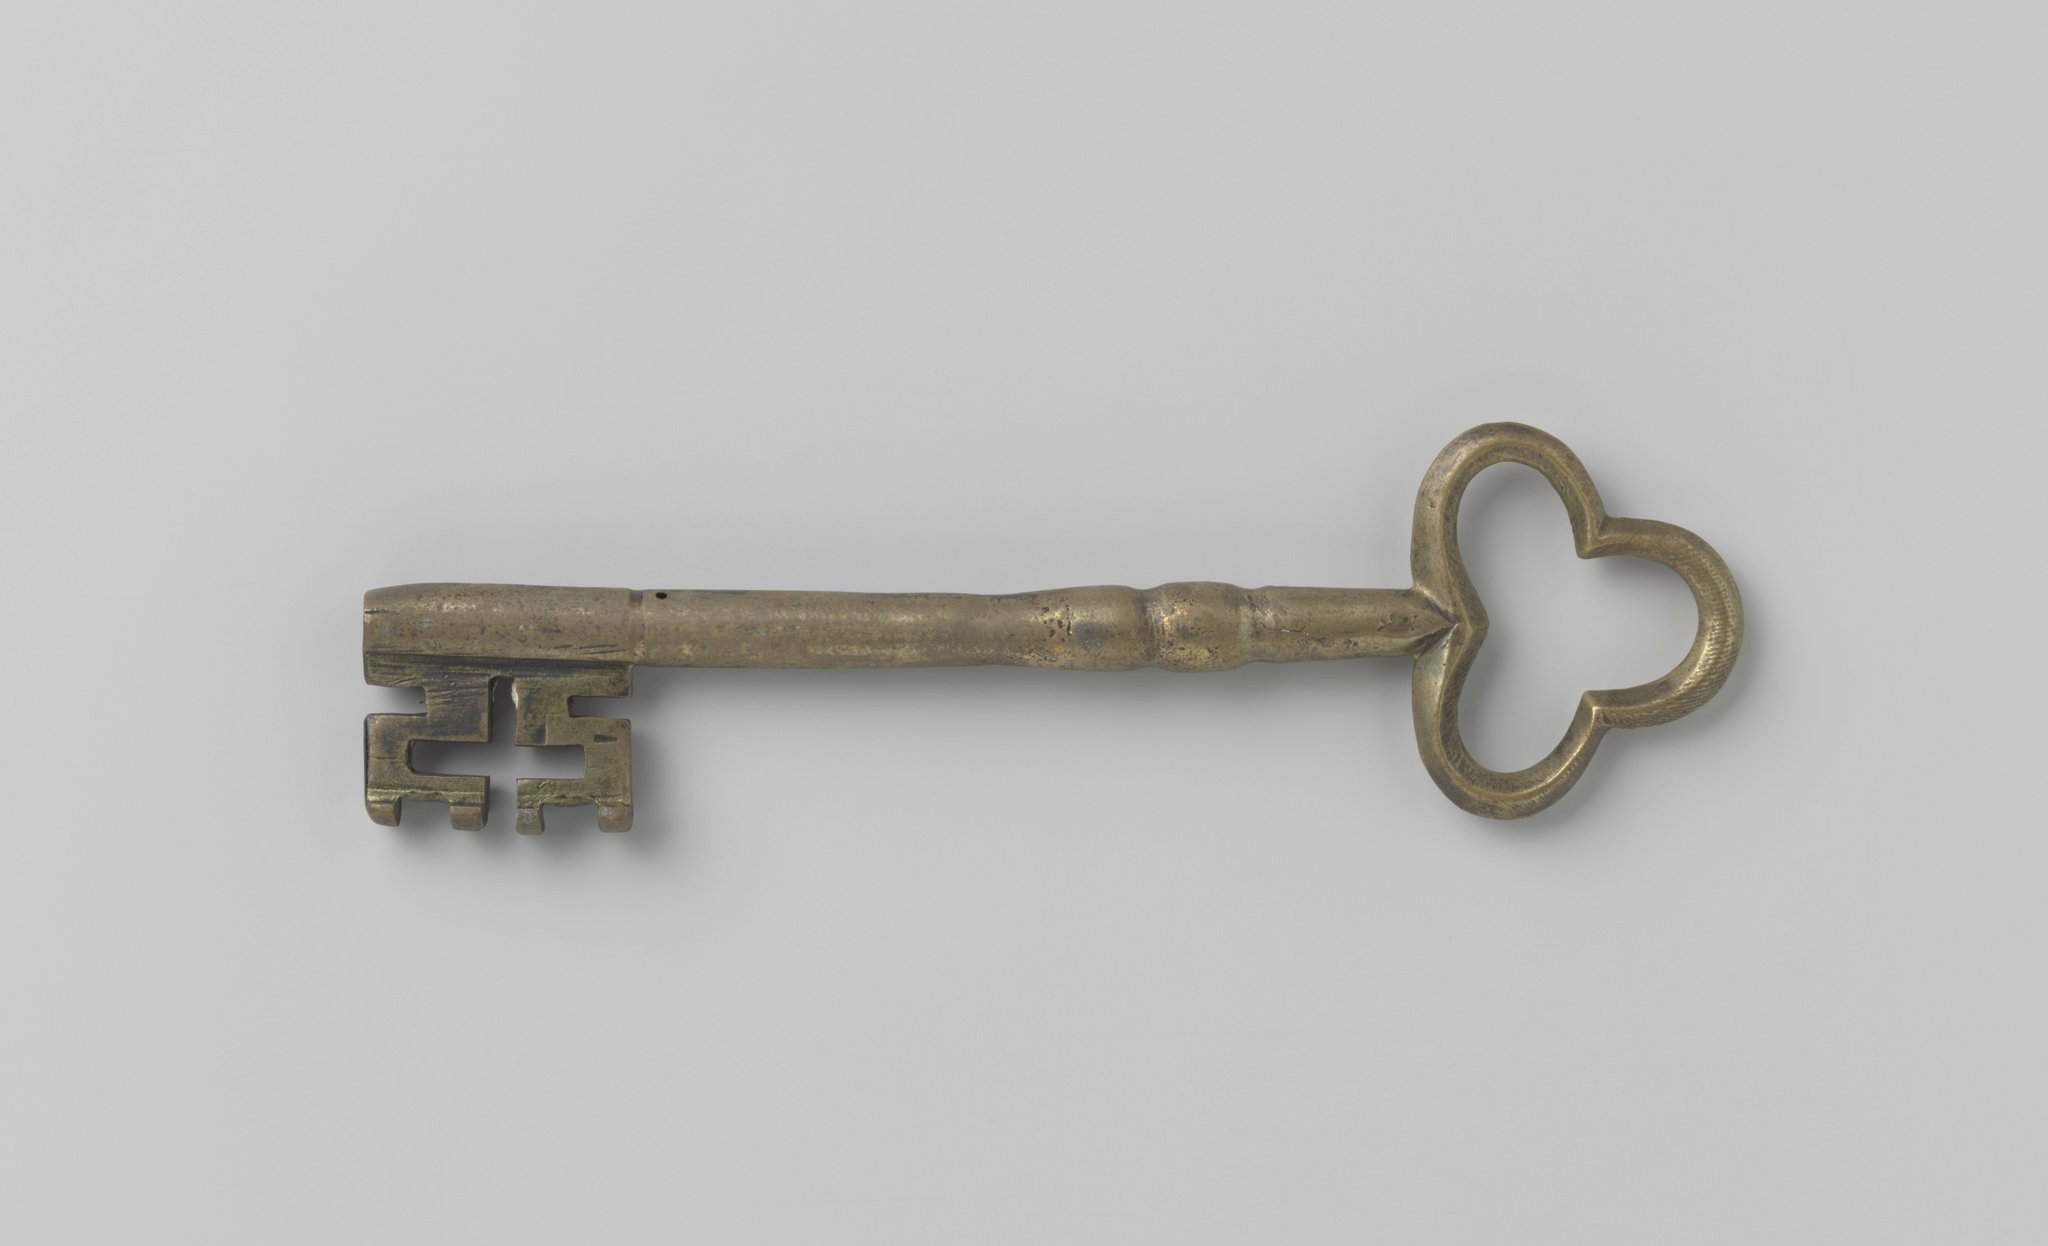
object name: key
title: Pijpsleutel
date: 1400-1600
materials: copper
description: Pijpsleutel met driepasvormig oog en symmetrisch ingesneden baard. De schacht vertoont in het midden twee opeen volgende verdikkingen.